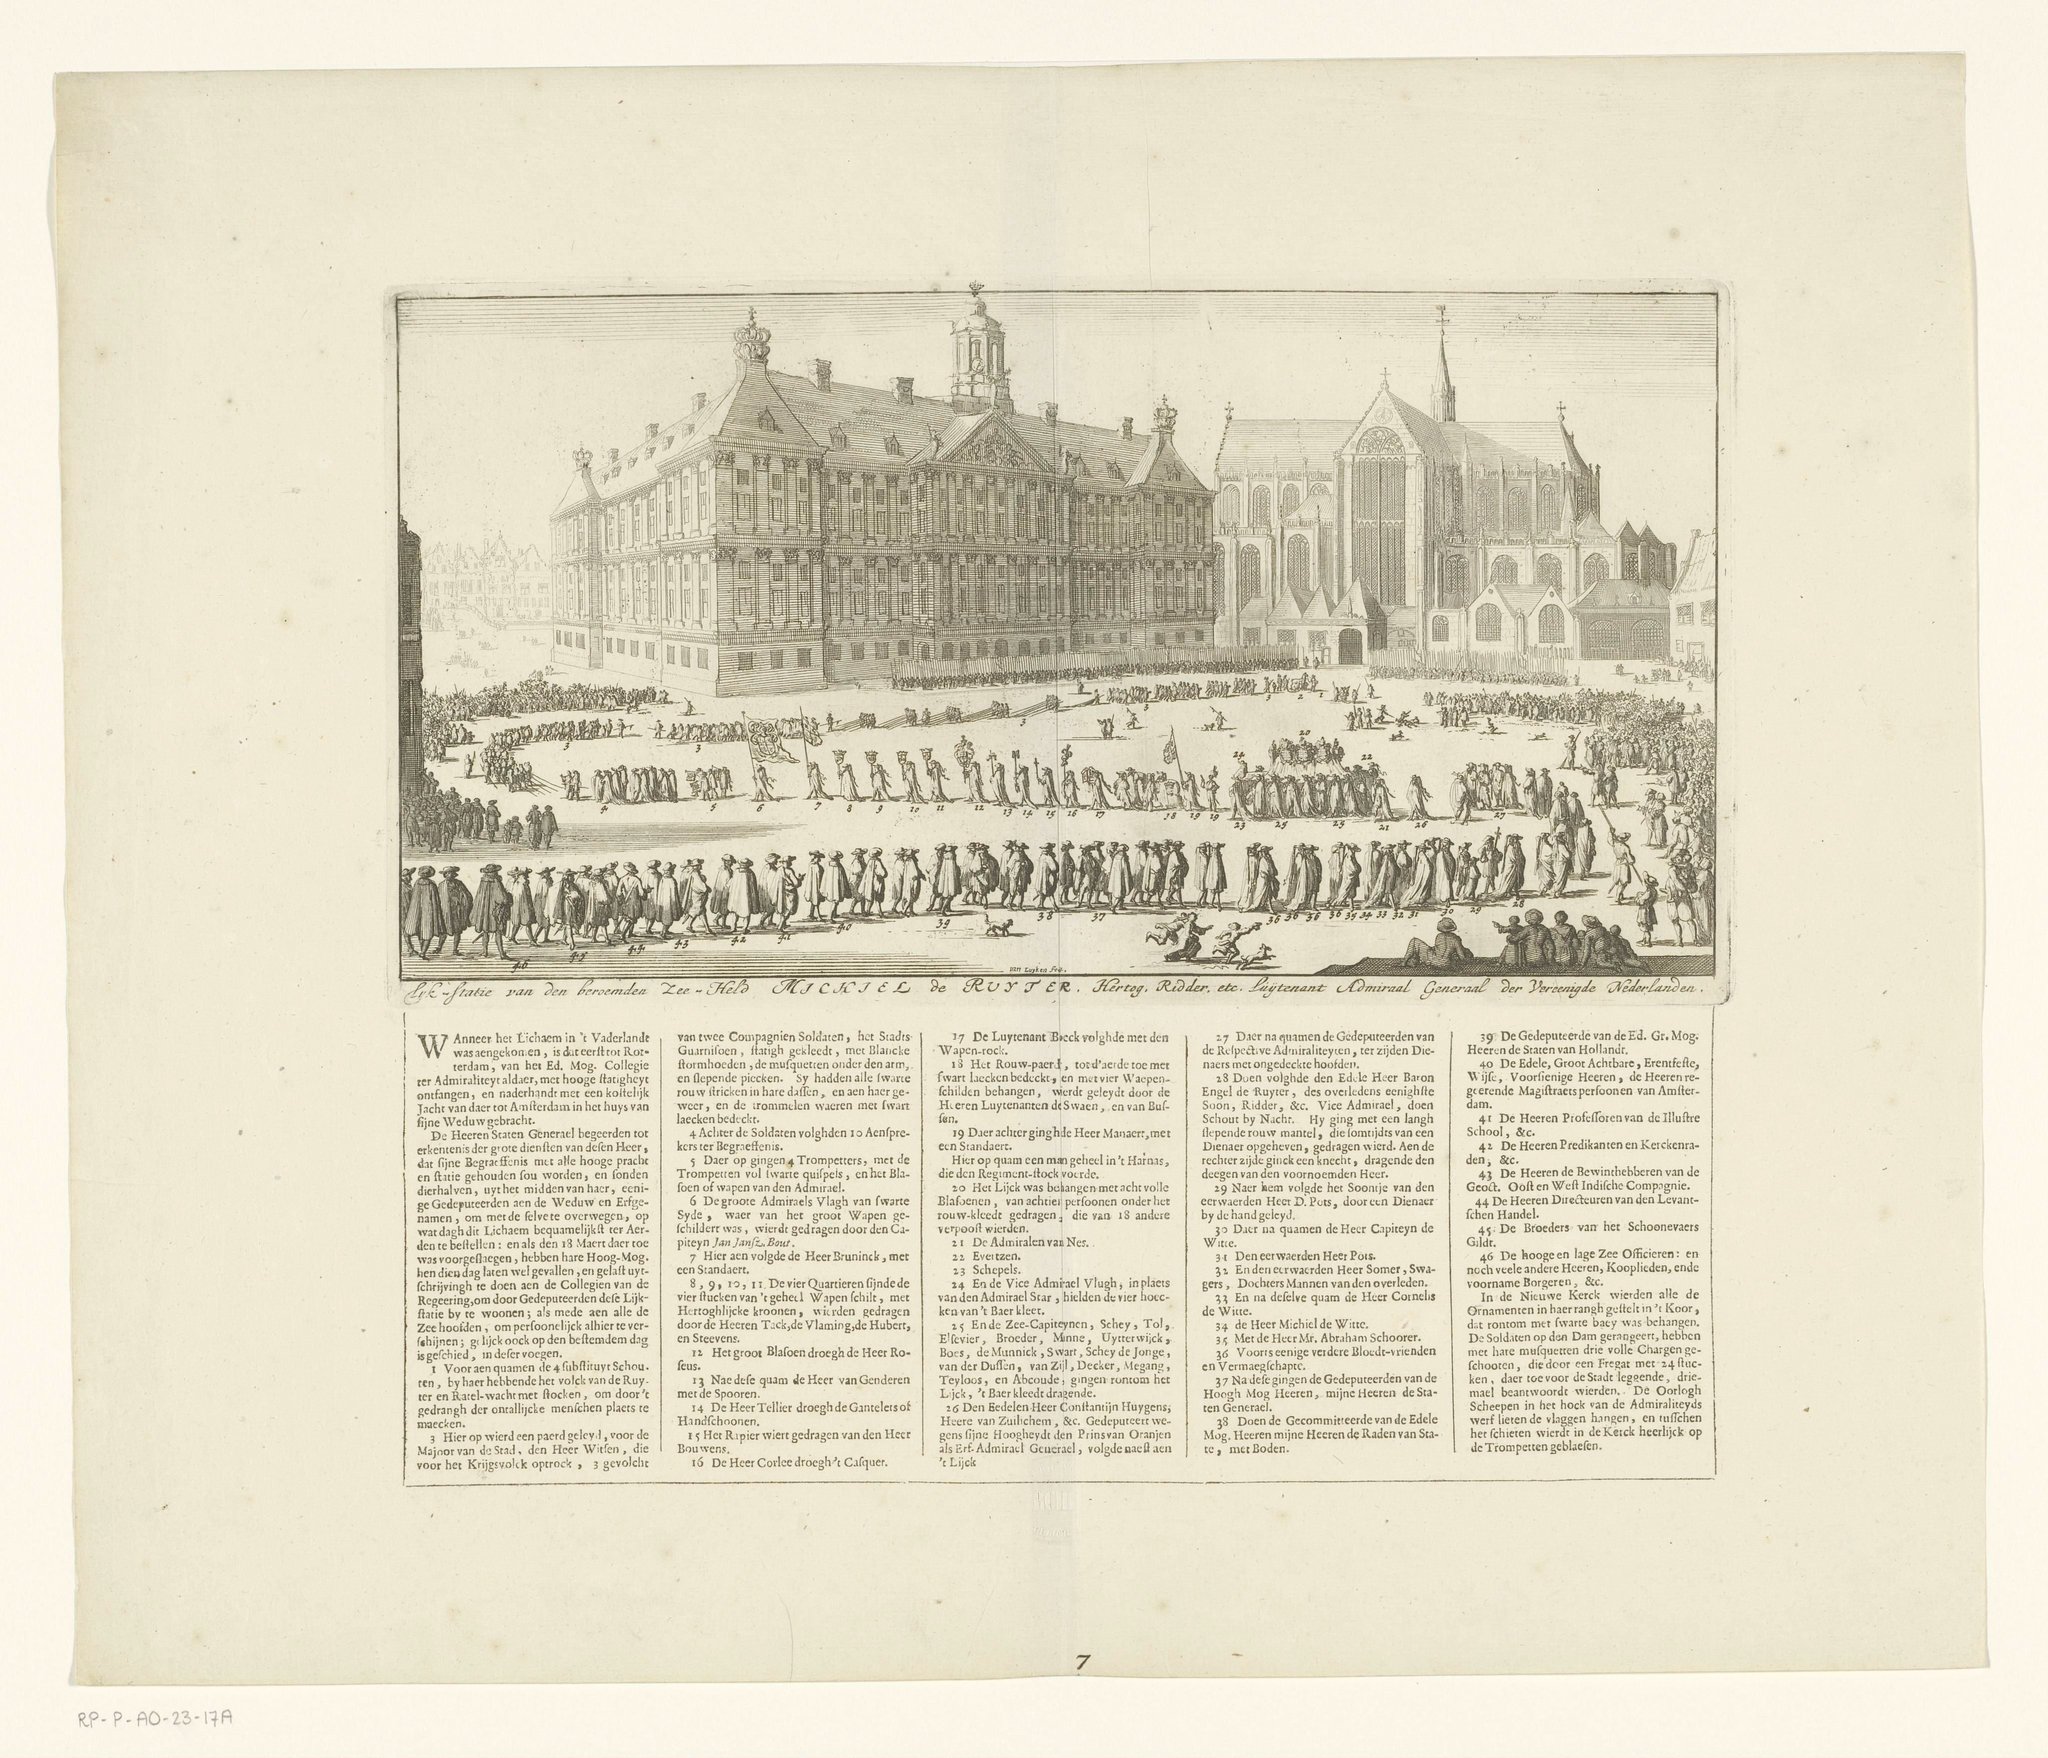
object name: print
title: Lyk-statie van den beroemden Zee-Held Michiel de Ruyter, Hertog, Ridder etc. Luijtenant Admiraal Generaal der Vereenigde Nederlanden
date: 1685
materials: paper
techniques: engraving, etching, letterpress printing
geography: amsterdam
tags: flushing, michiel adriaenszoon de ruyter, cortege, funeral procession, church (exterior), townhall, funerary ceremonial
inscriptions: check stamp: ‘Archief Ministerie van Oorlog Afdeeling Genie’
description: Prent gebruikt in: Bosch, Lambert van den. Historien onses tyds, behelzende saken van staat en oorlogh, voorgevallen in, en omtrent de Vereenigde Nederlanden, en door geheel Europa (…). 3 delen. Amsterdam: Jan Claesz ten Hoorn en Jan Bouman (I), 1685-1699, dl. 1 (1685). Eerdere staat van prent (RP-P-1896-A-19368-401) gebruikt in: Bosch, Lambert van den. Leeven en daaden der doorluchtigste zee-helden (…). Amsterdam: Jan Claesz ten Hoorn en Jan Bouman (I), 1683, p. 781.